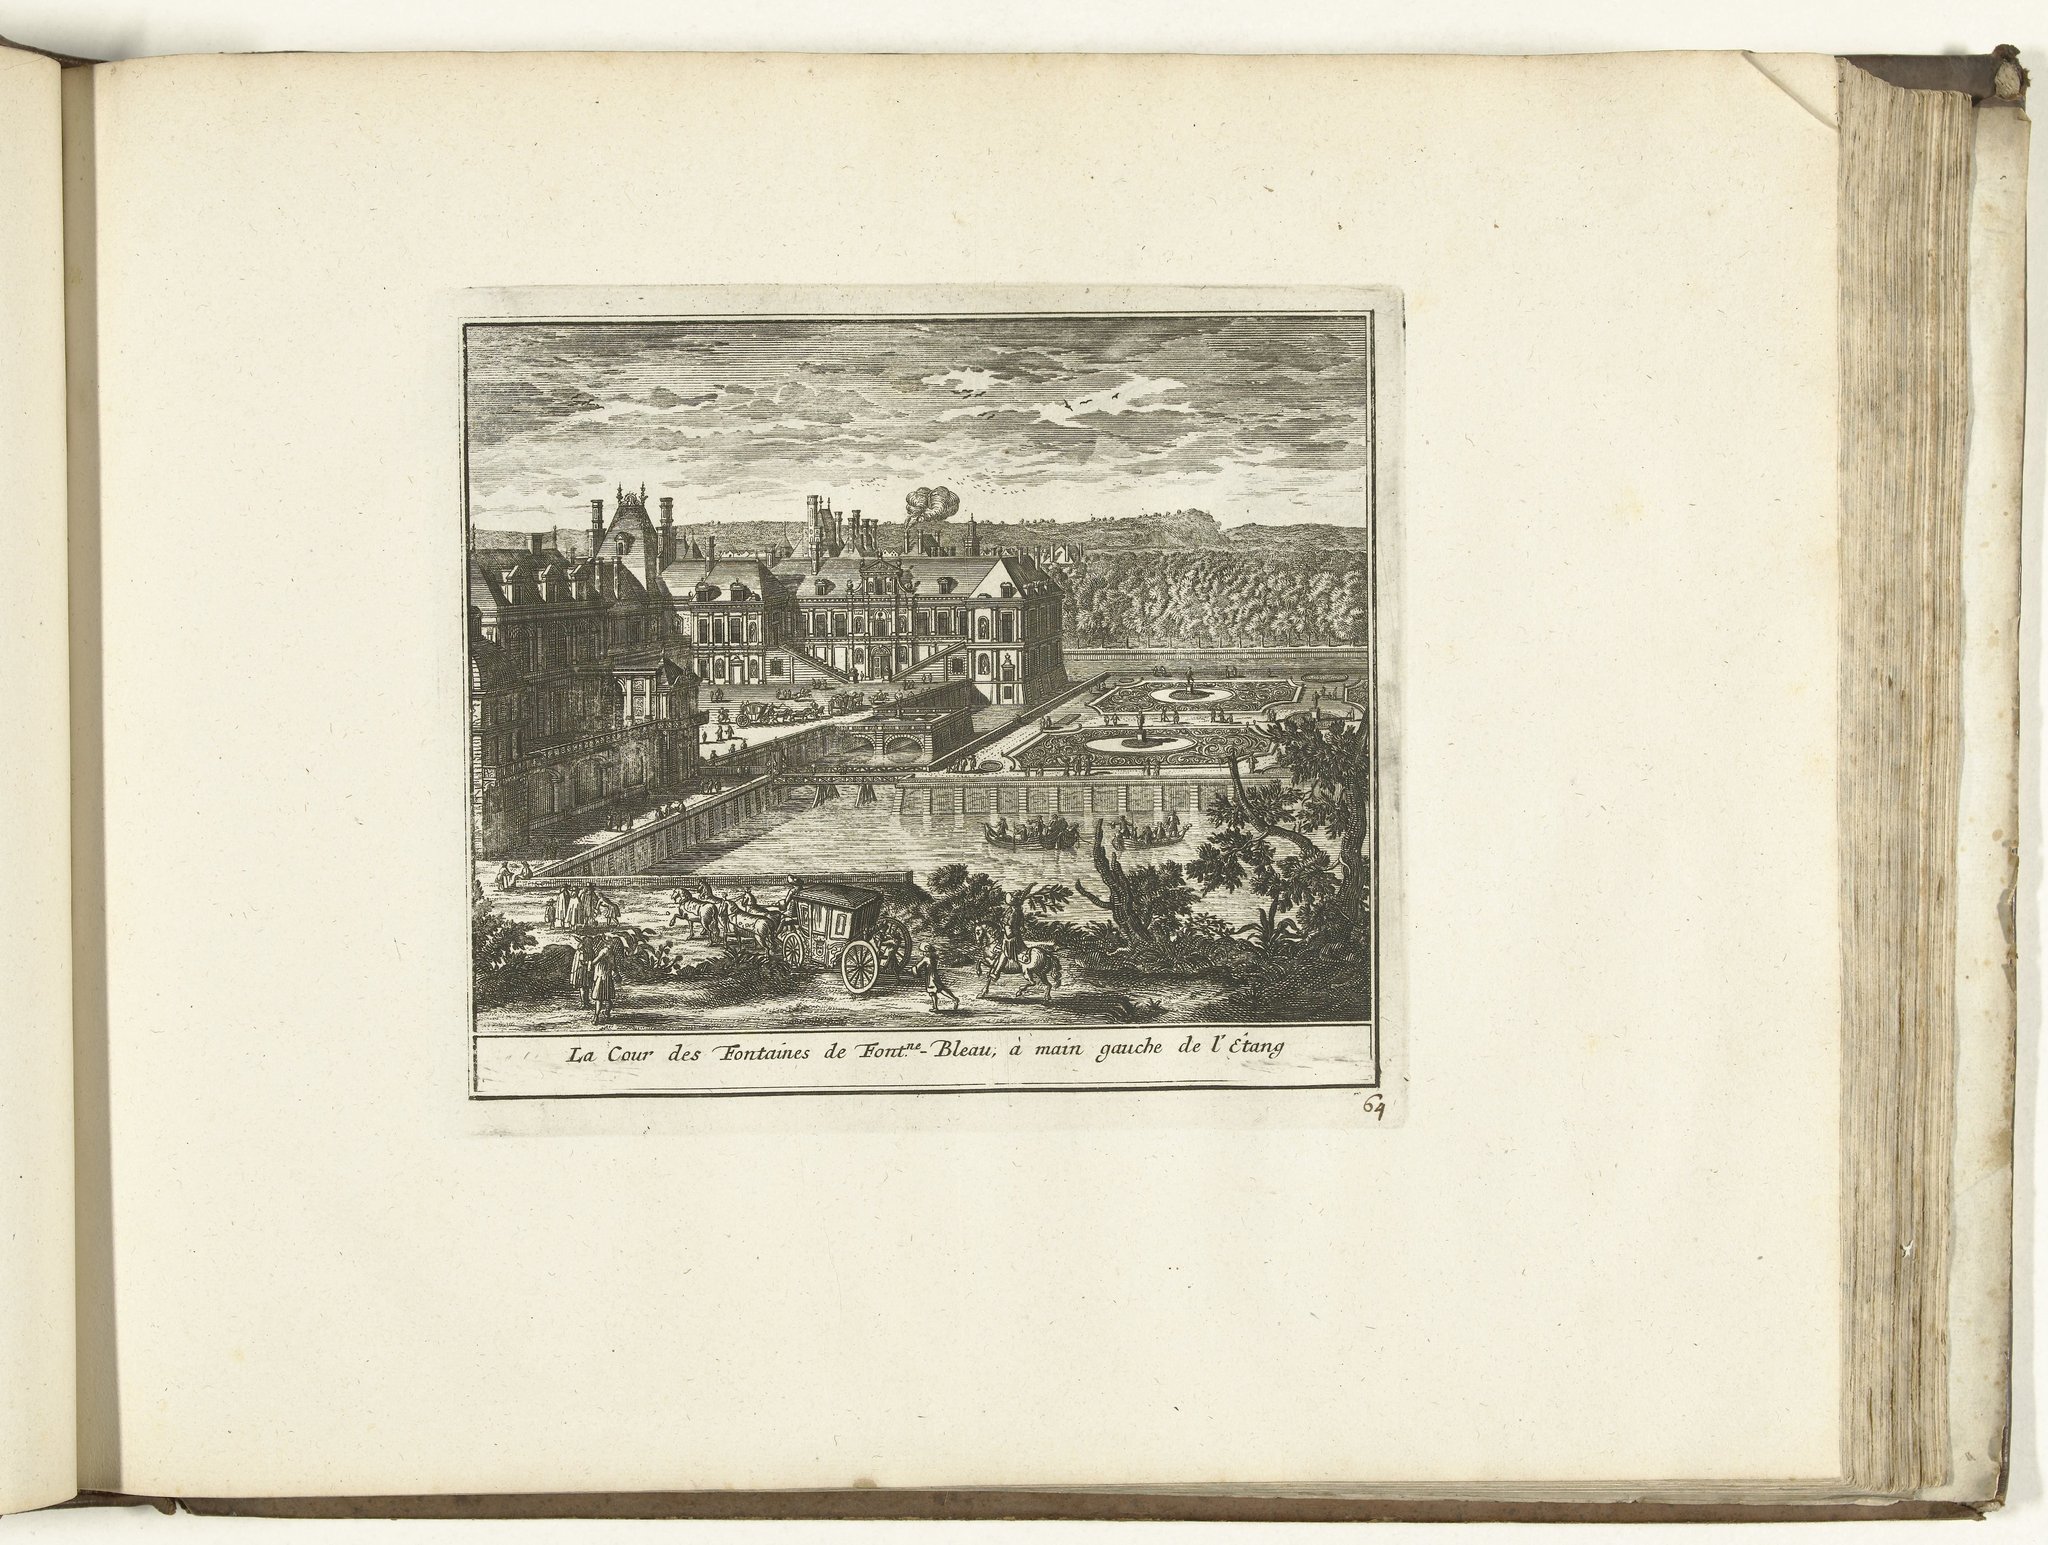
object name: print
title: La Cour des Fontaines de Fontne.-Bleau; à main gauche de l'Etang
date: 1726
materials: paper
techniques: etching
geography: northern netherlands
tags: palace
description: Gezicht op de Cour de la Fontaine in het paleis van Fontainebleau. Plaat nr. 64 in deel III van het prentwerk: Les Forces de l'Europe, Asie, Afrique et Amerique ... Comme aussi les Cartes des Côtes de France et d'Espagne uit 1726, dit eerste deel met 238 met de hand genummerde platen van vermaarde sterke steden en vestingen in het kader van de Spaanse Successieoorlog 1701-1713. Voor het merendeel zijn deze platen gekopieerd naar de anonieme Franse platen van vermaarde sterke steden en vestingen: in Les forces de l'Europe en in: Le theatre de la guerre, dans les Pays-Bas, beide oorspronkelijk uitgegeven door Nicolas de Fer te Parijs (1693-1697) in het kader van de Negenjarige Oorlog. Titel in het Frans.